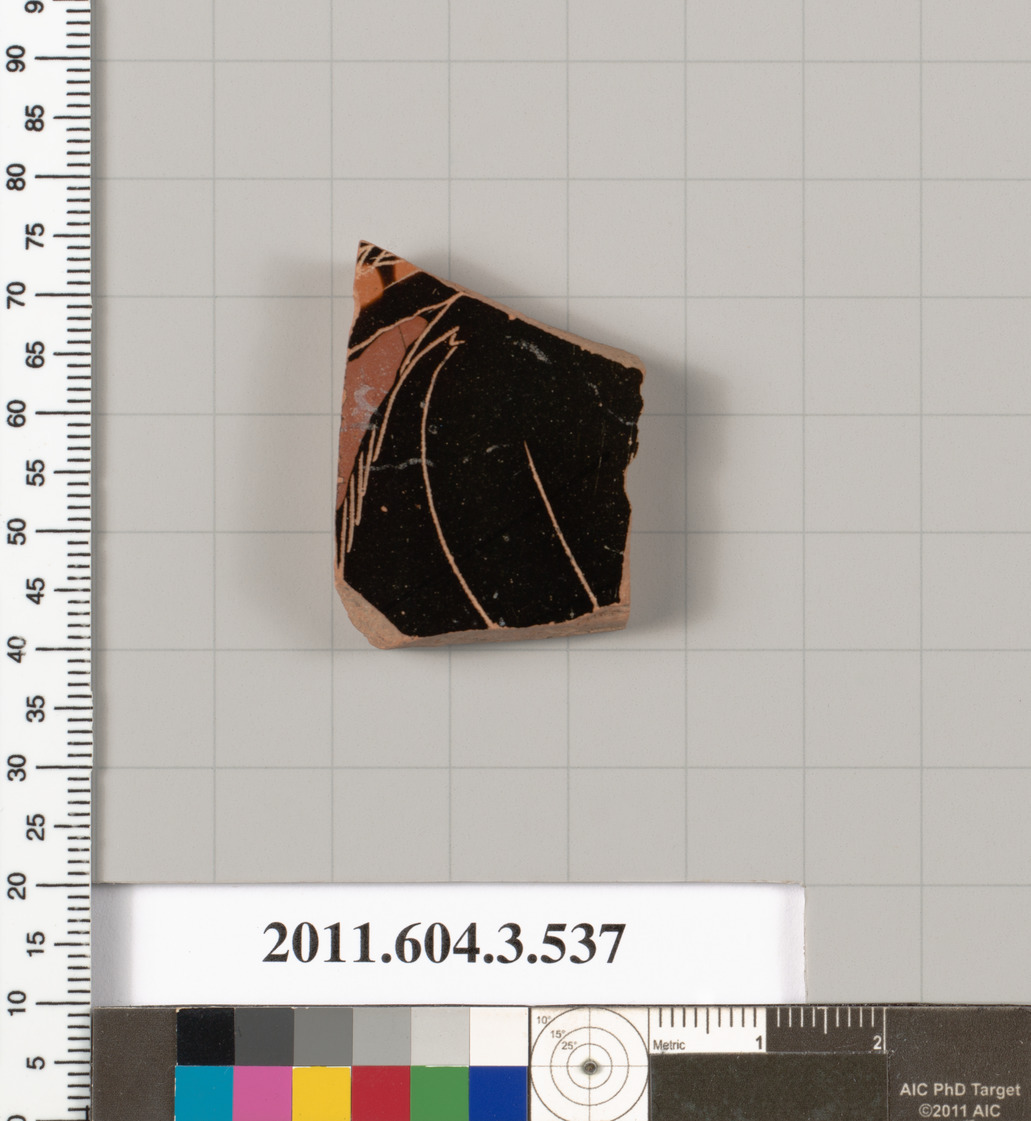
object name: column krater fragment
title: Terracotta fragment of a column-krater (bowl for mixing wine and water)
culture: greek, attic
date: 534-501 BCE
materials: terracotta